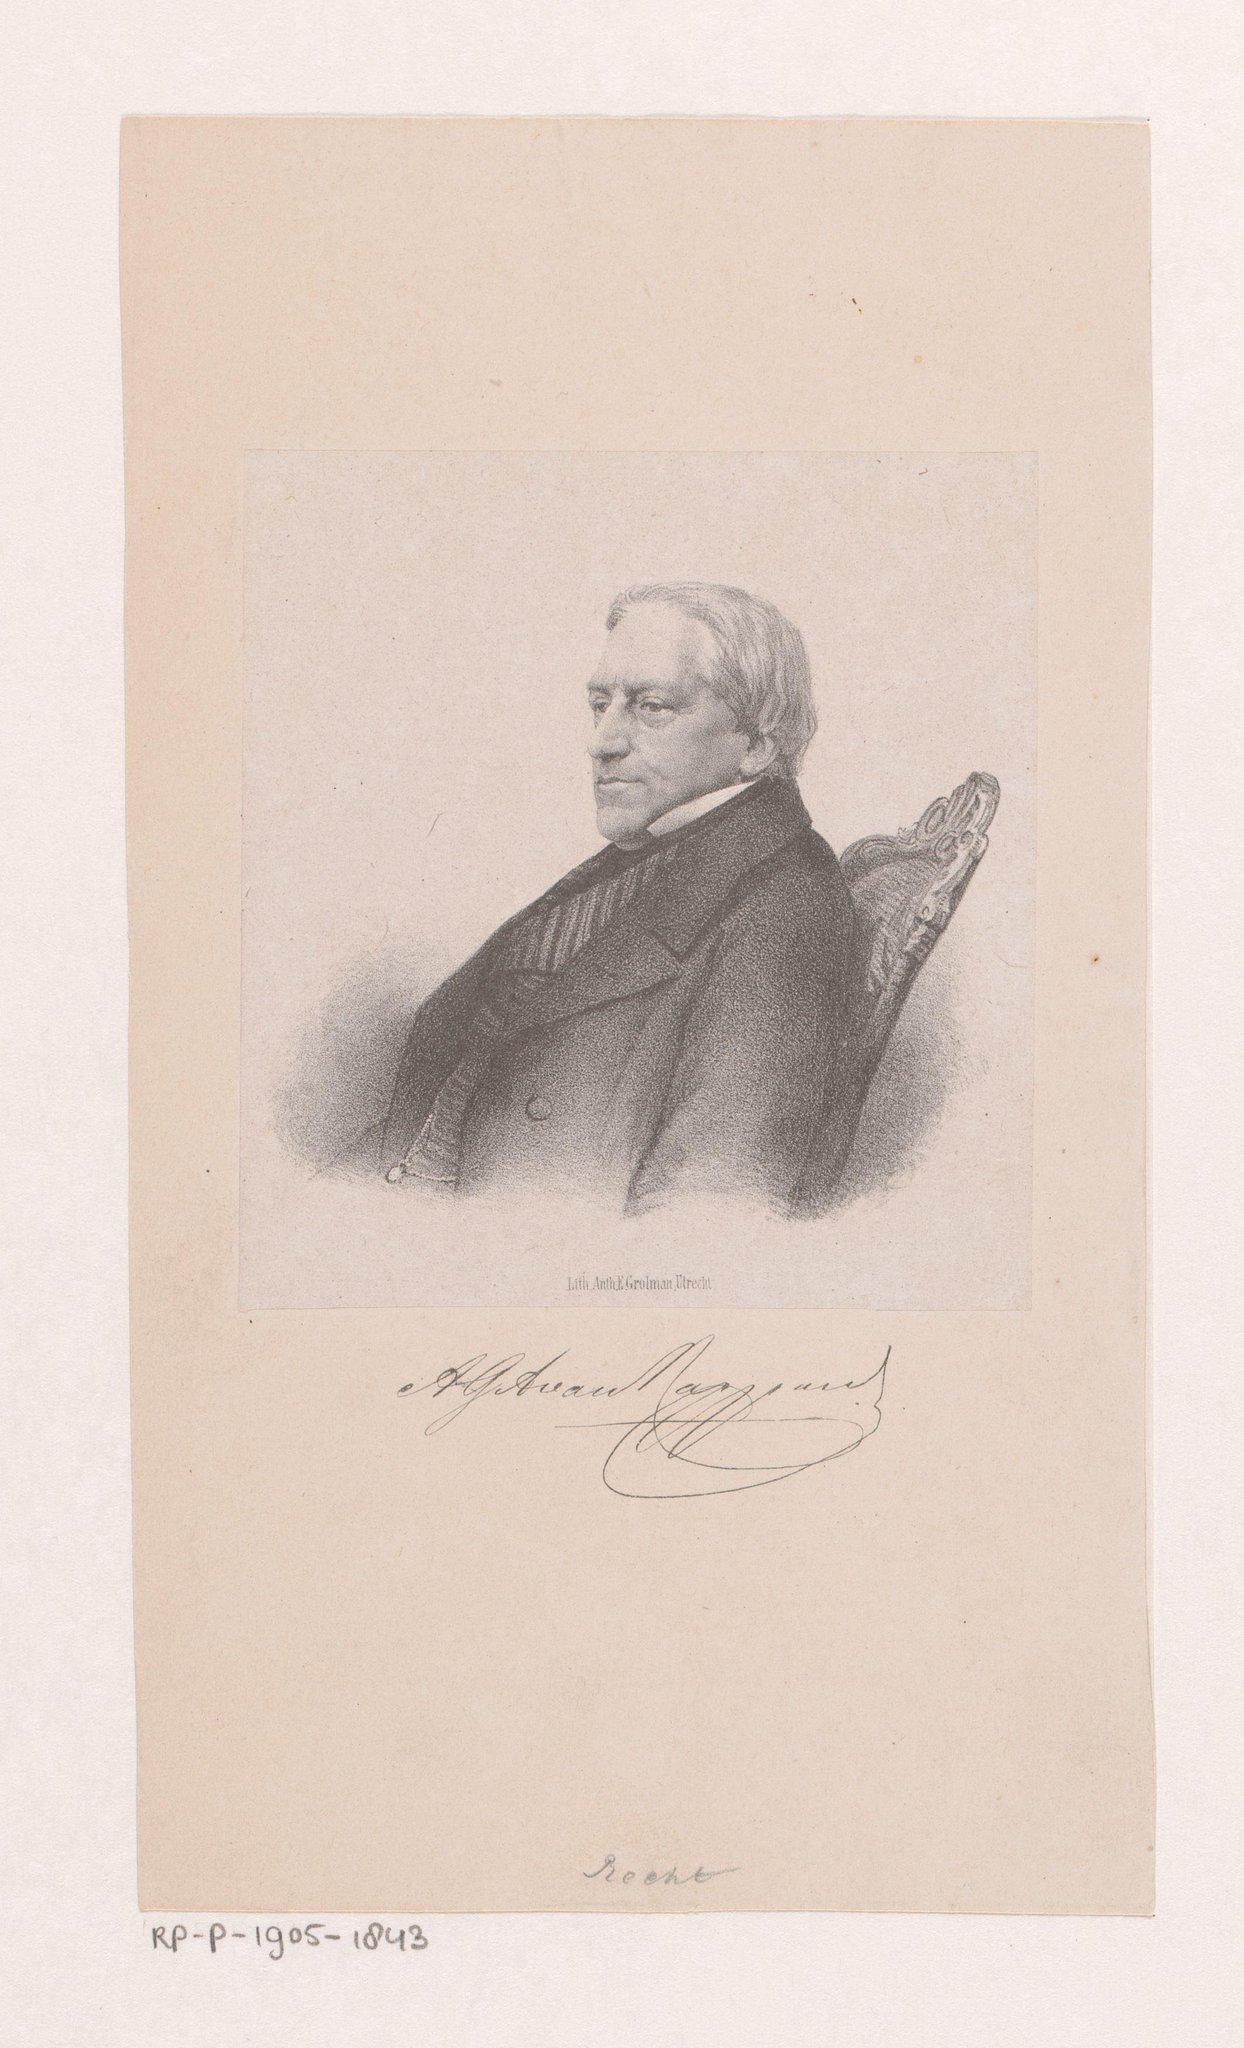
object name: print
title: Portret van Anthon Gerard Alexander van Rappard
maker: anthony grolman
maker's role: draughtsman, print maker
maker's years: 1843-1926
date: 1853-1905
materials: paper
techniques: lithograph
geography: utrecht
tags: anthon gerard alexander van rappard, historical persons (+ (full) bust portrait)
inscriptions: collector's mark: Lugt 2228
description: De geportretteerde zit op een stoel naar links gedraaid. Onder het portret zijn signatuur.